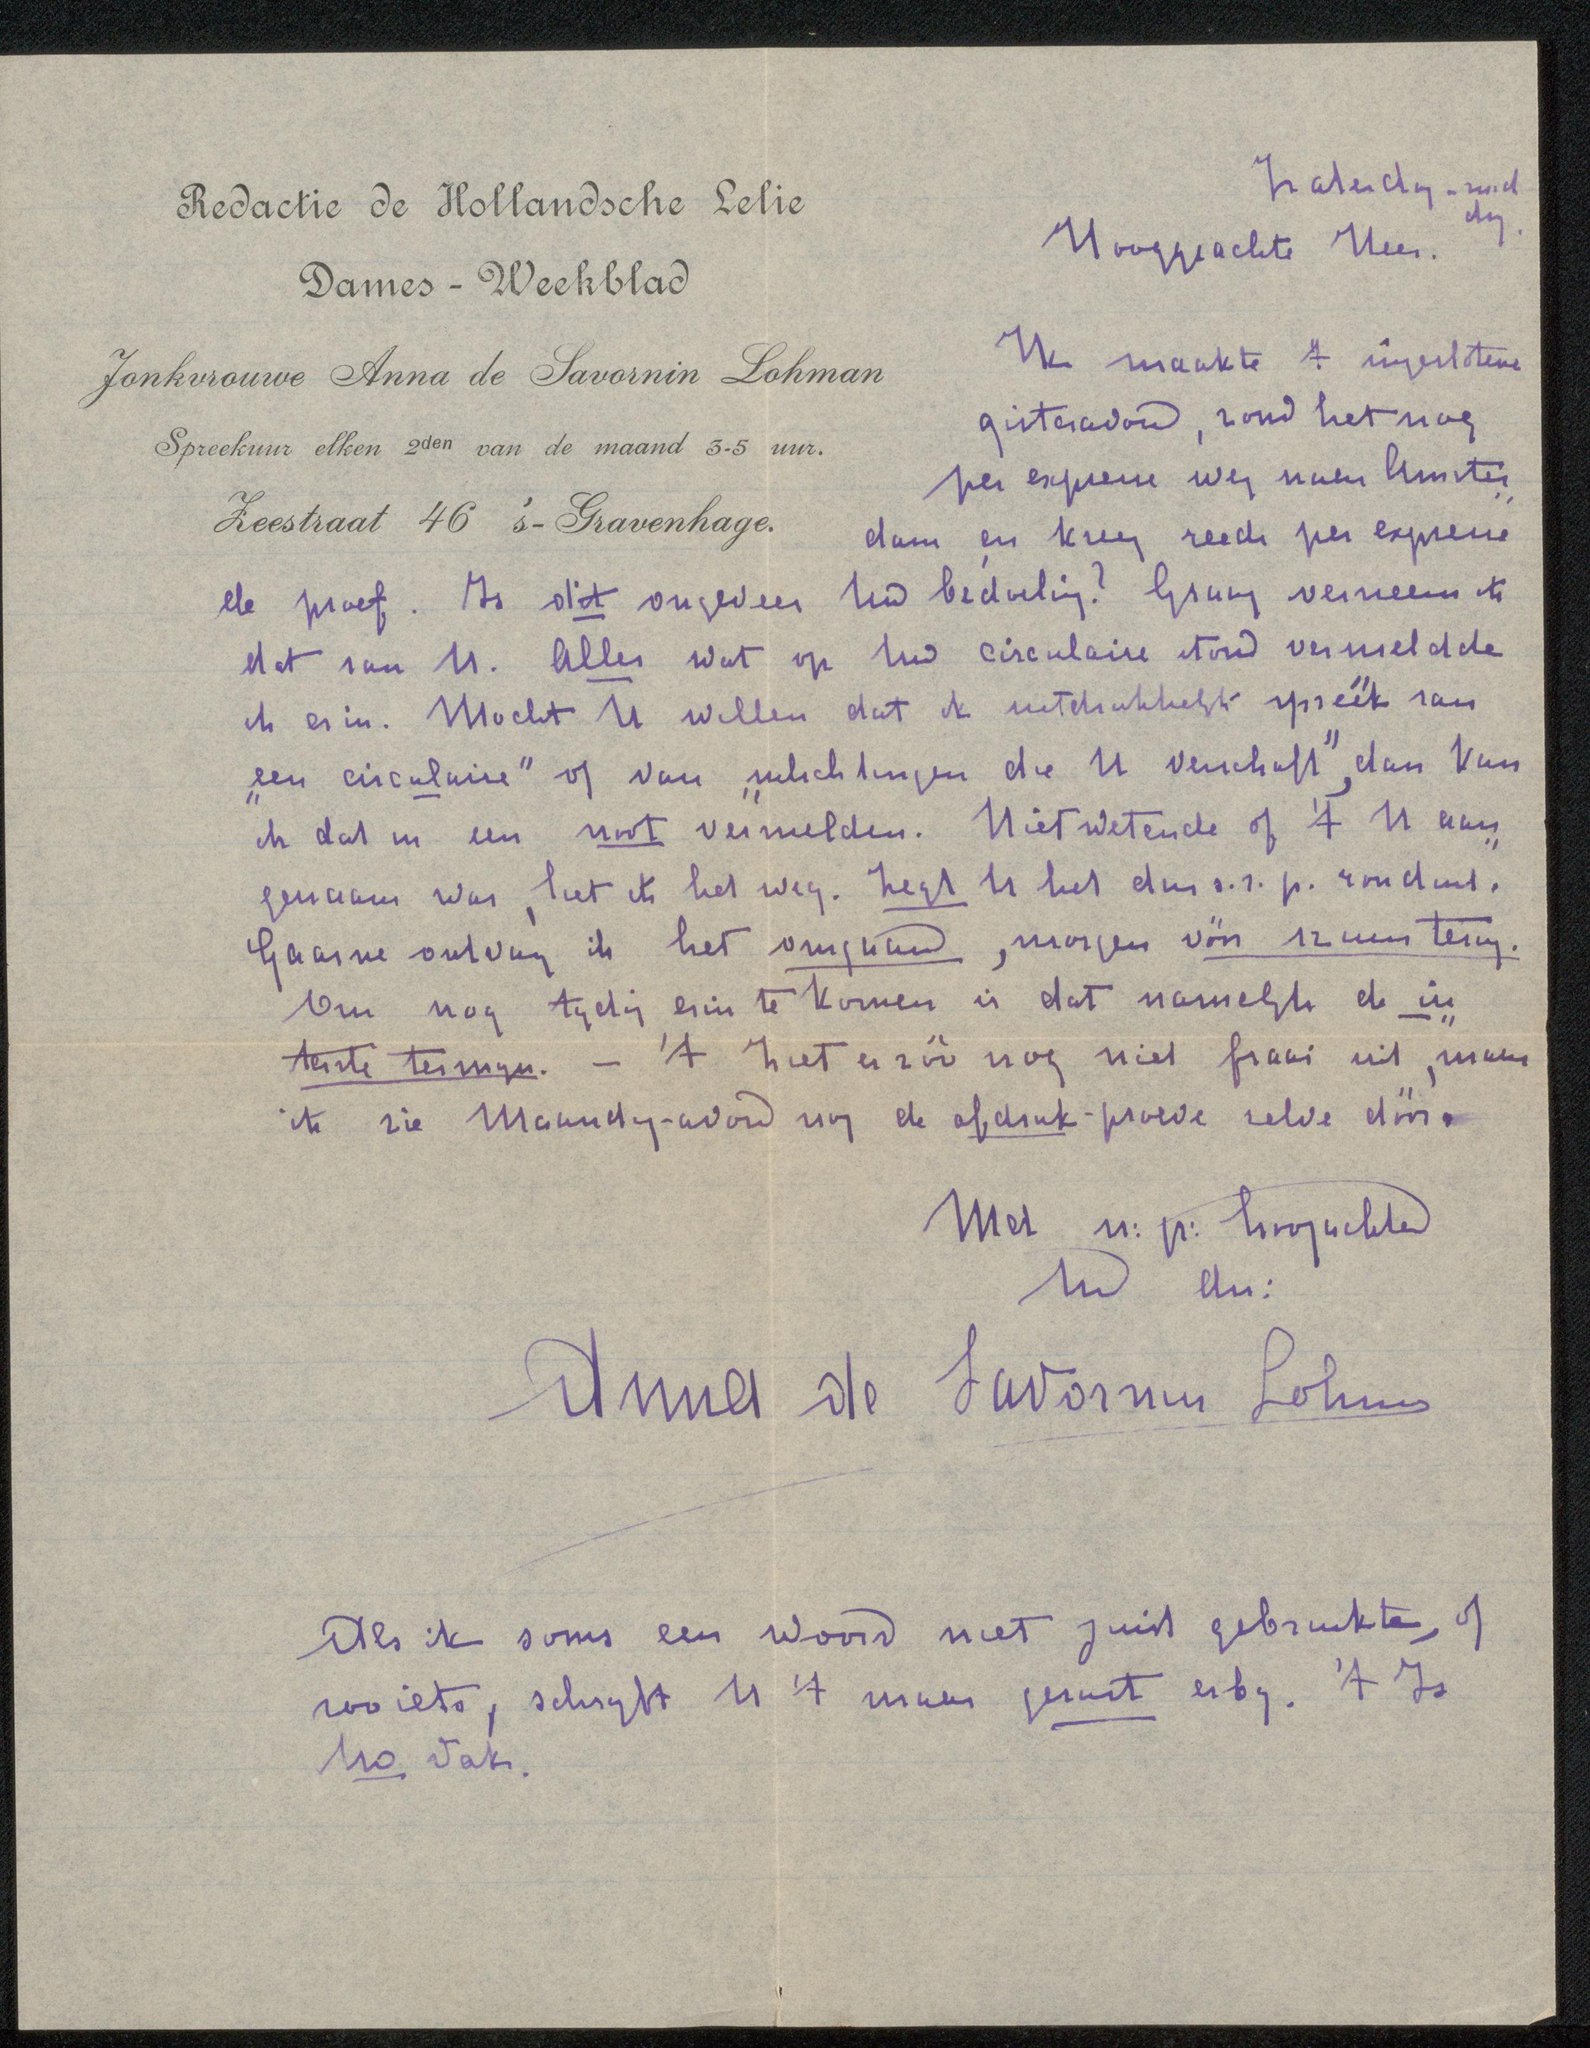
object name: letter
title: Brief aan Philip Zilcken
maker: jonkvrouw catharina anna maria de savornin lohman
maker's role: criticus, journalist, schrijver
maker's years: 1868-1930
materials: ink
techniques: pen, printing, writing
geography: the hague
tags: painter, draughtsman, philip zilcken, printed matter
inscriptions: collector's mark: ‘RPK’